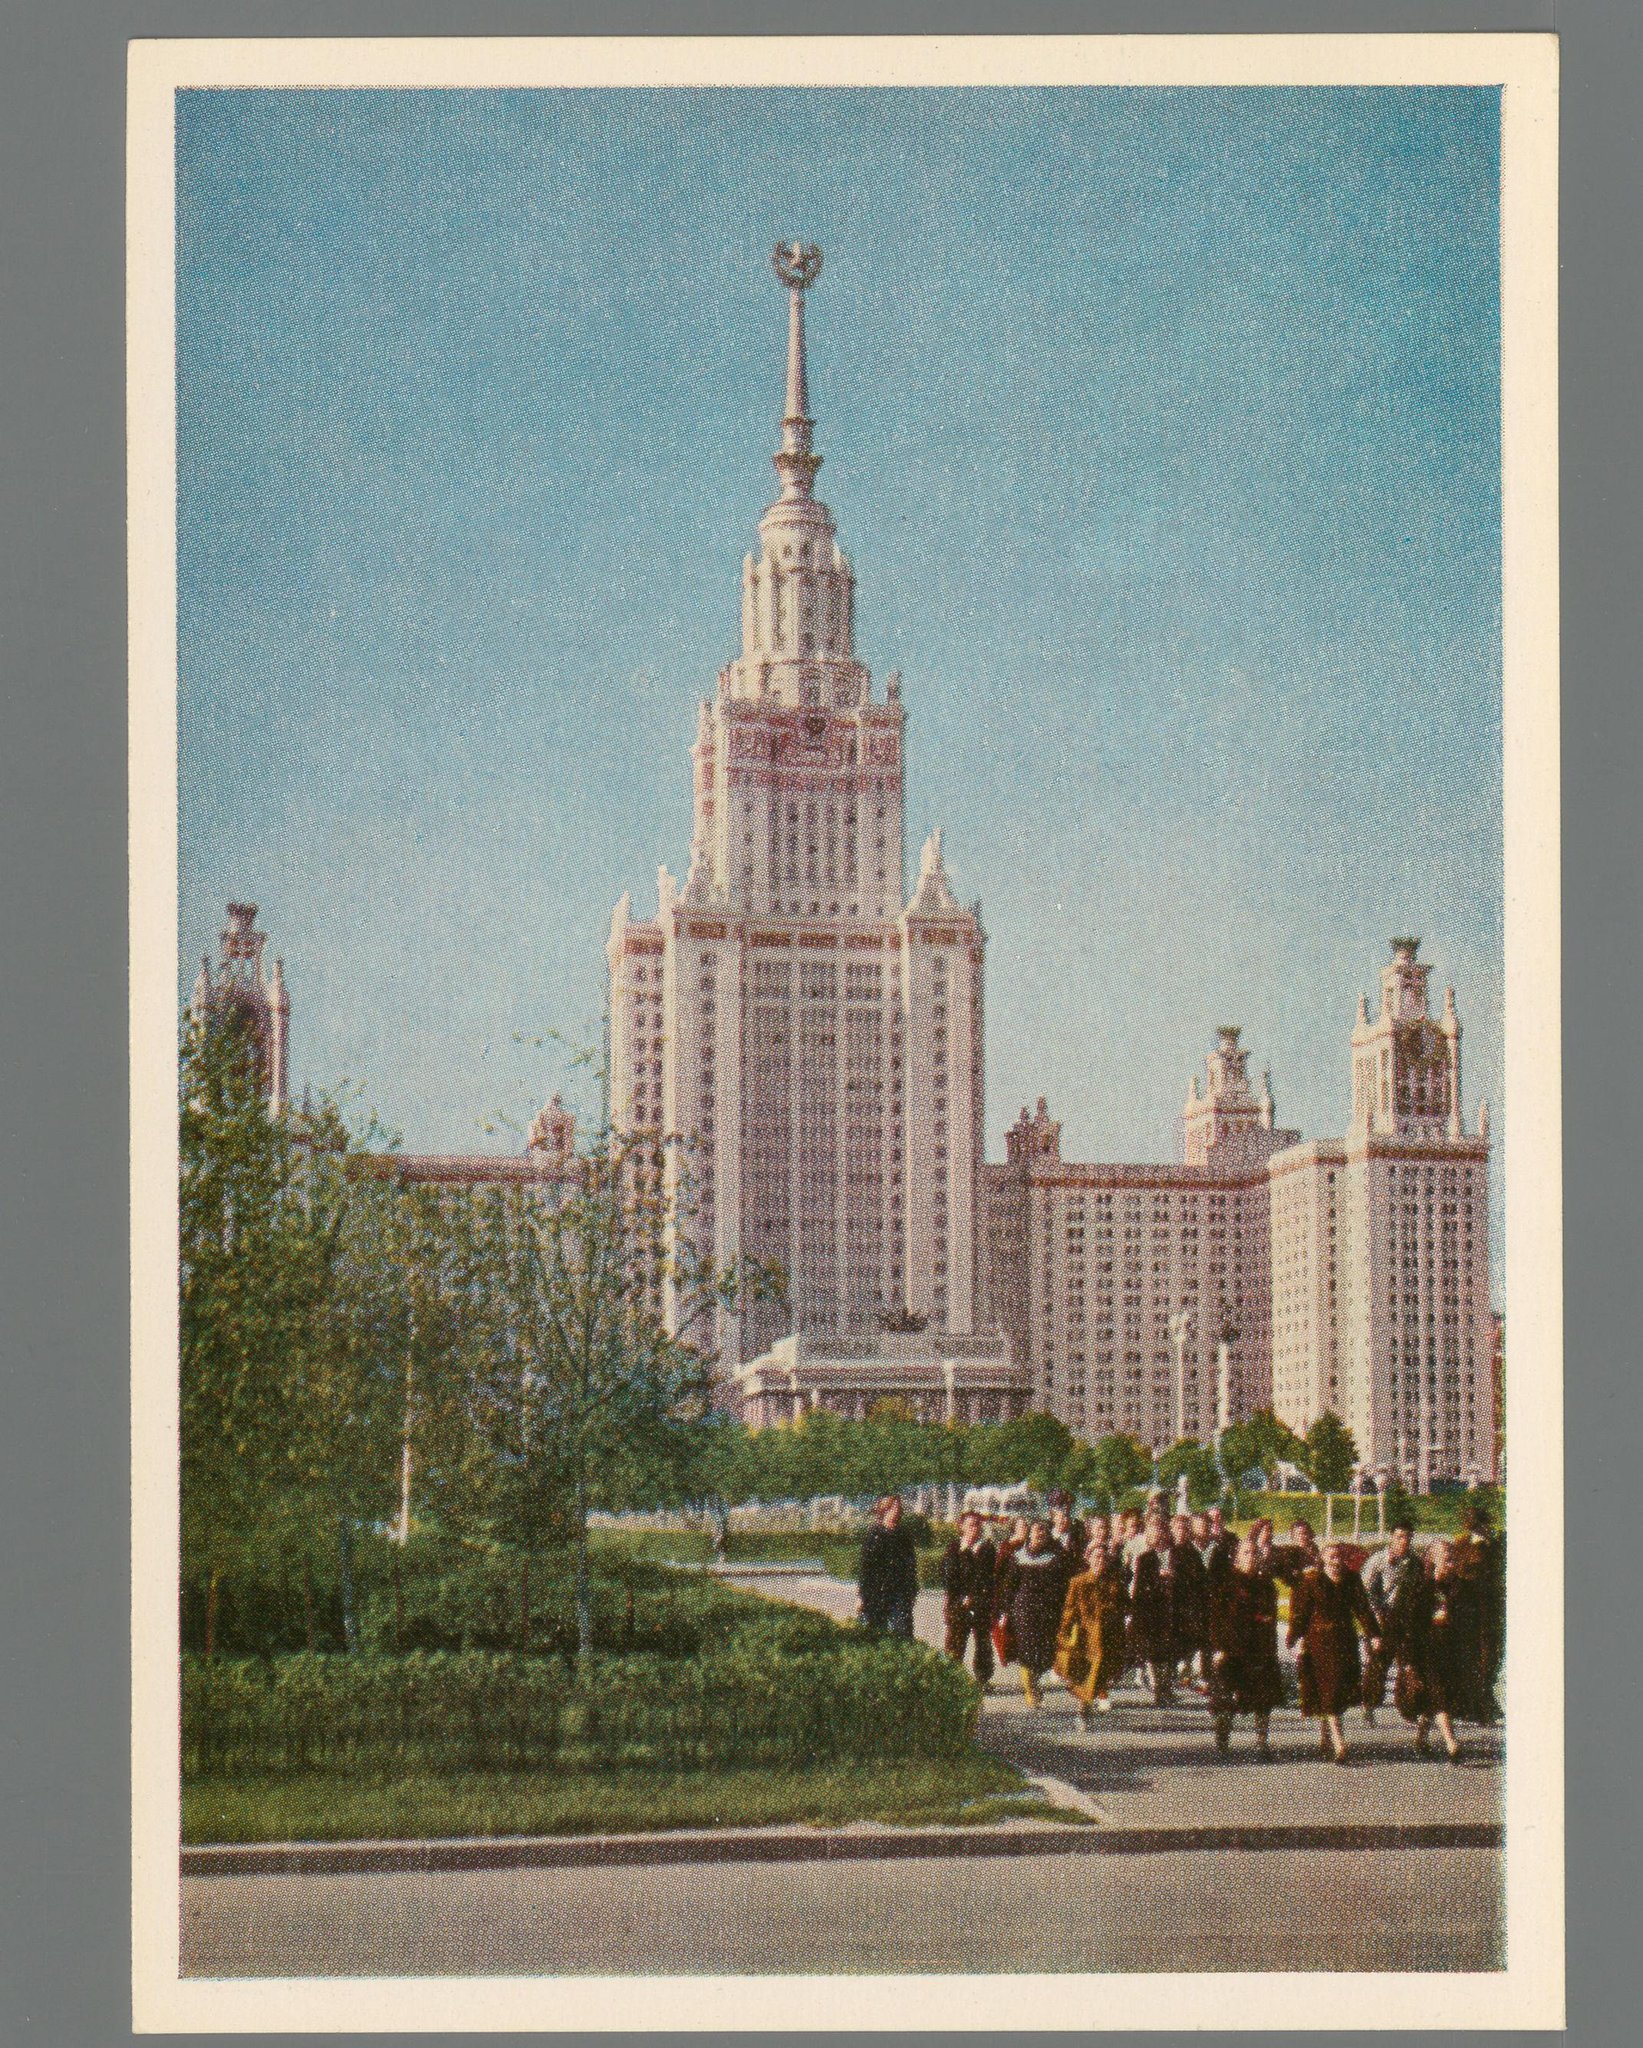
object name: ansichtkaart, prentbriefkaart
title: Moscow. Moscow State University, Lenin Hills. Main Building / Moskau. Hauptgebäude der Moskauer Staatlichen Universität auf den Leninbergen / Moscou. Edifice principal de l'Université de Moscou sur les Monts Lénine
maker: Anonymous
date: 1956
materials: cardboard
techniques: color autotype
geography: moscow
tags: university building, college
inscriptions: date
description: De titel op object staat ook in het Russisch.